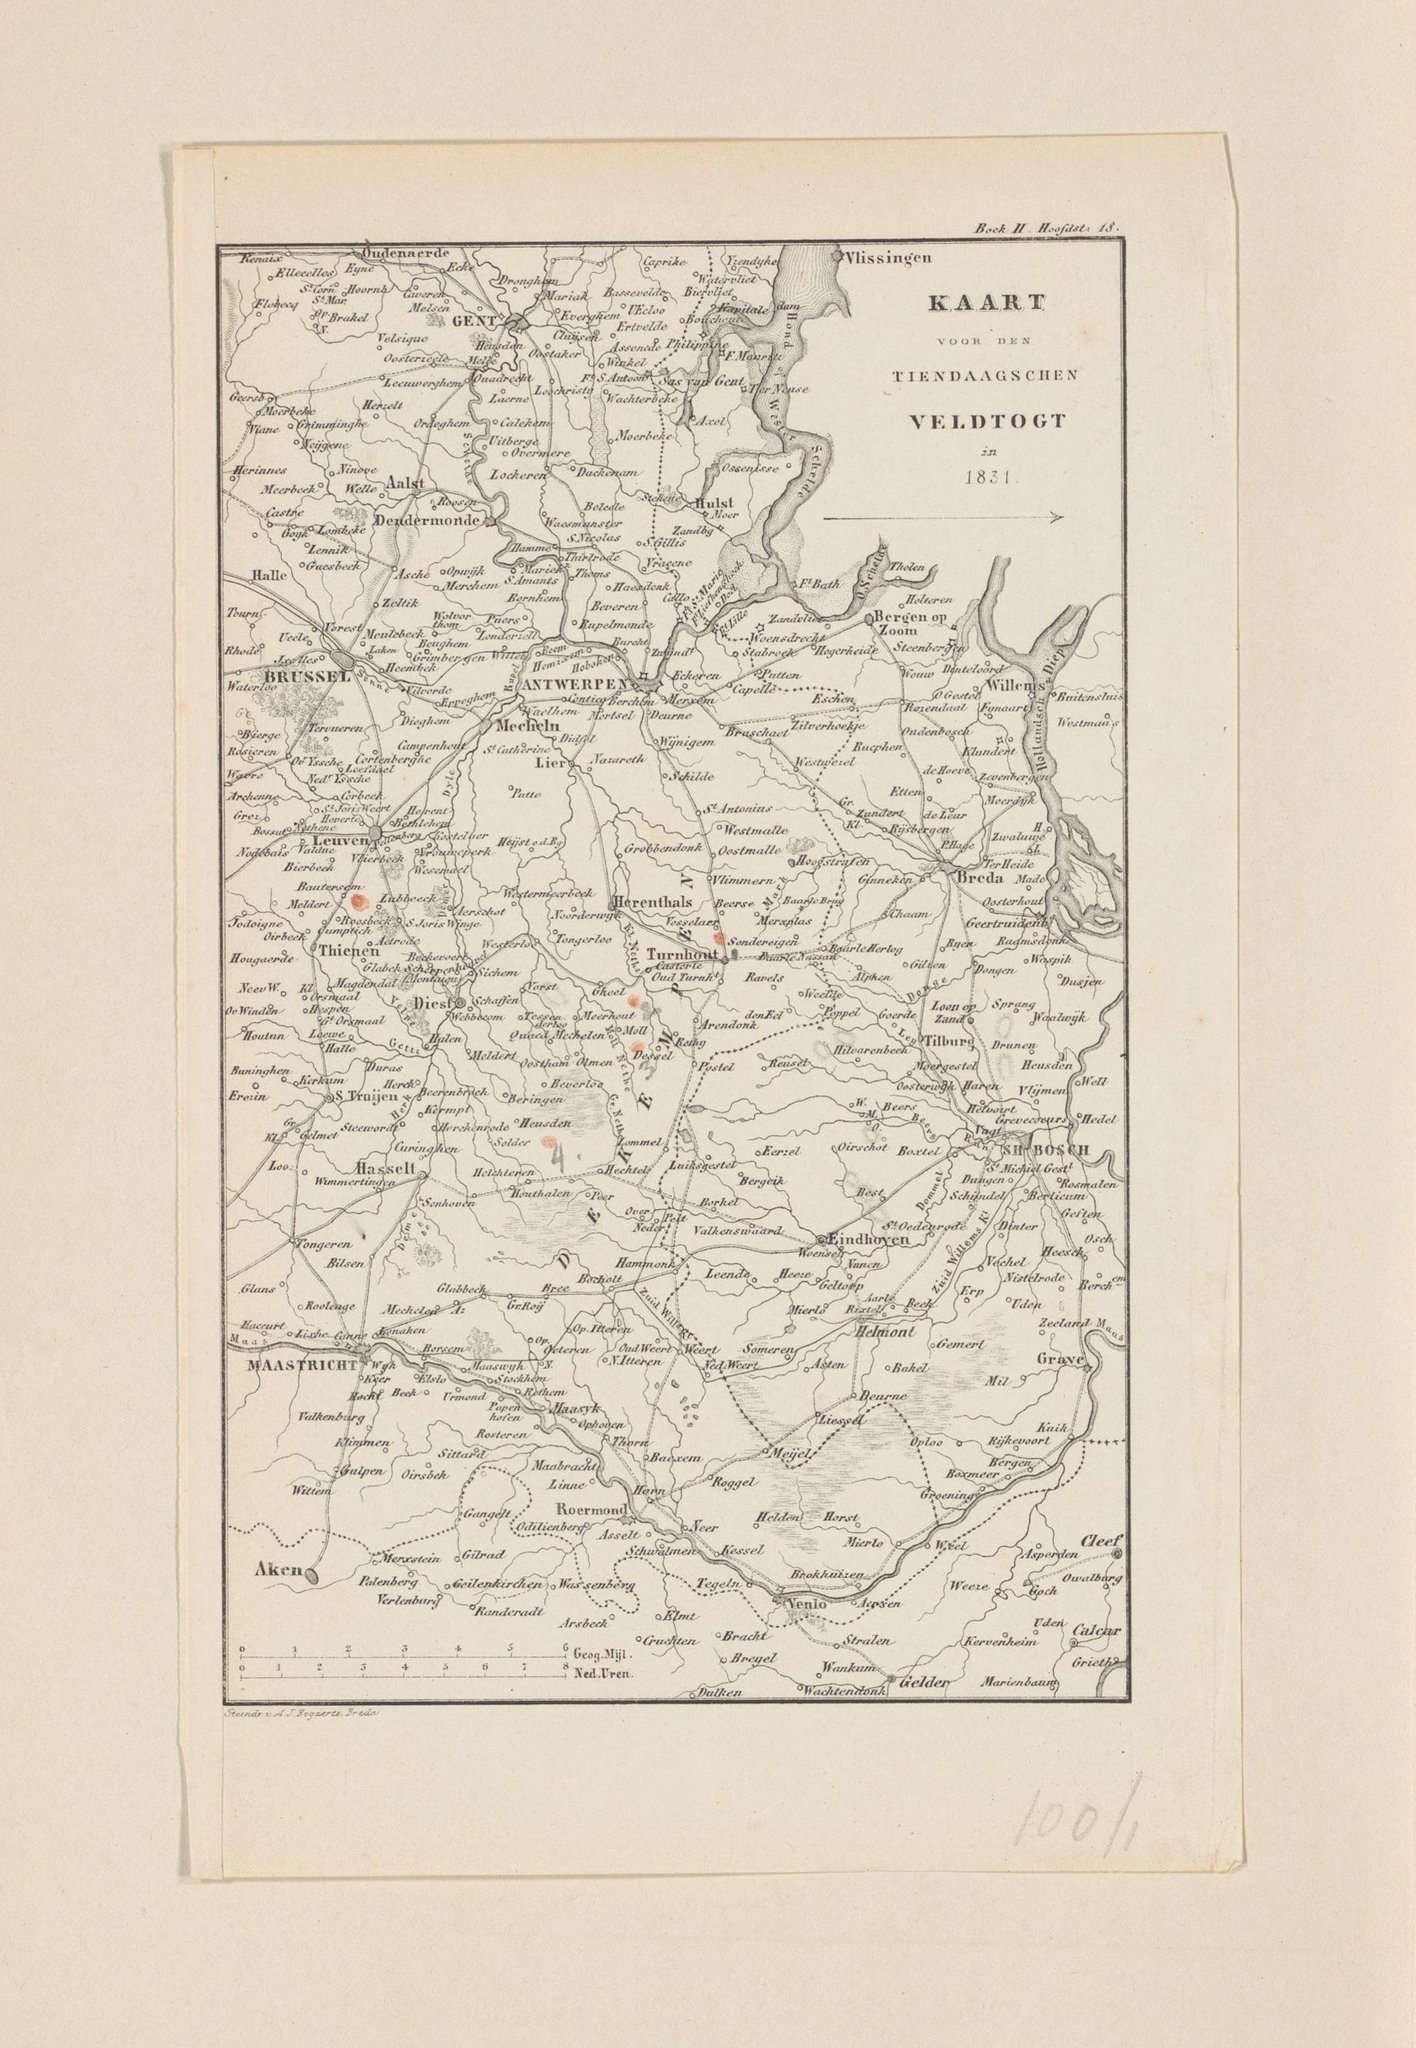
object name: map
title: Kaart voor den Tiendaagschen Veldtogt in 1831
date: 1845-1882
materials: paper, pencil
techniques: lithograph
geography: breda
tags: maps of separate countries or regions, netherlands, belgium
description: Kaart (uit een boek) van het grensgebied van België en Nederland, het terrein van de Tiendaagse Veldtocht 2-12 augustus 1831, met rode potloodpunt waarbij cijfers.